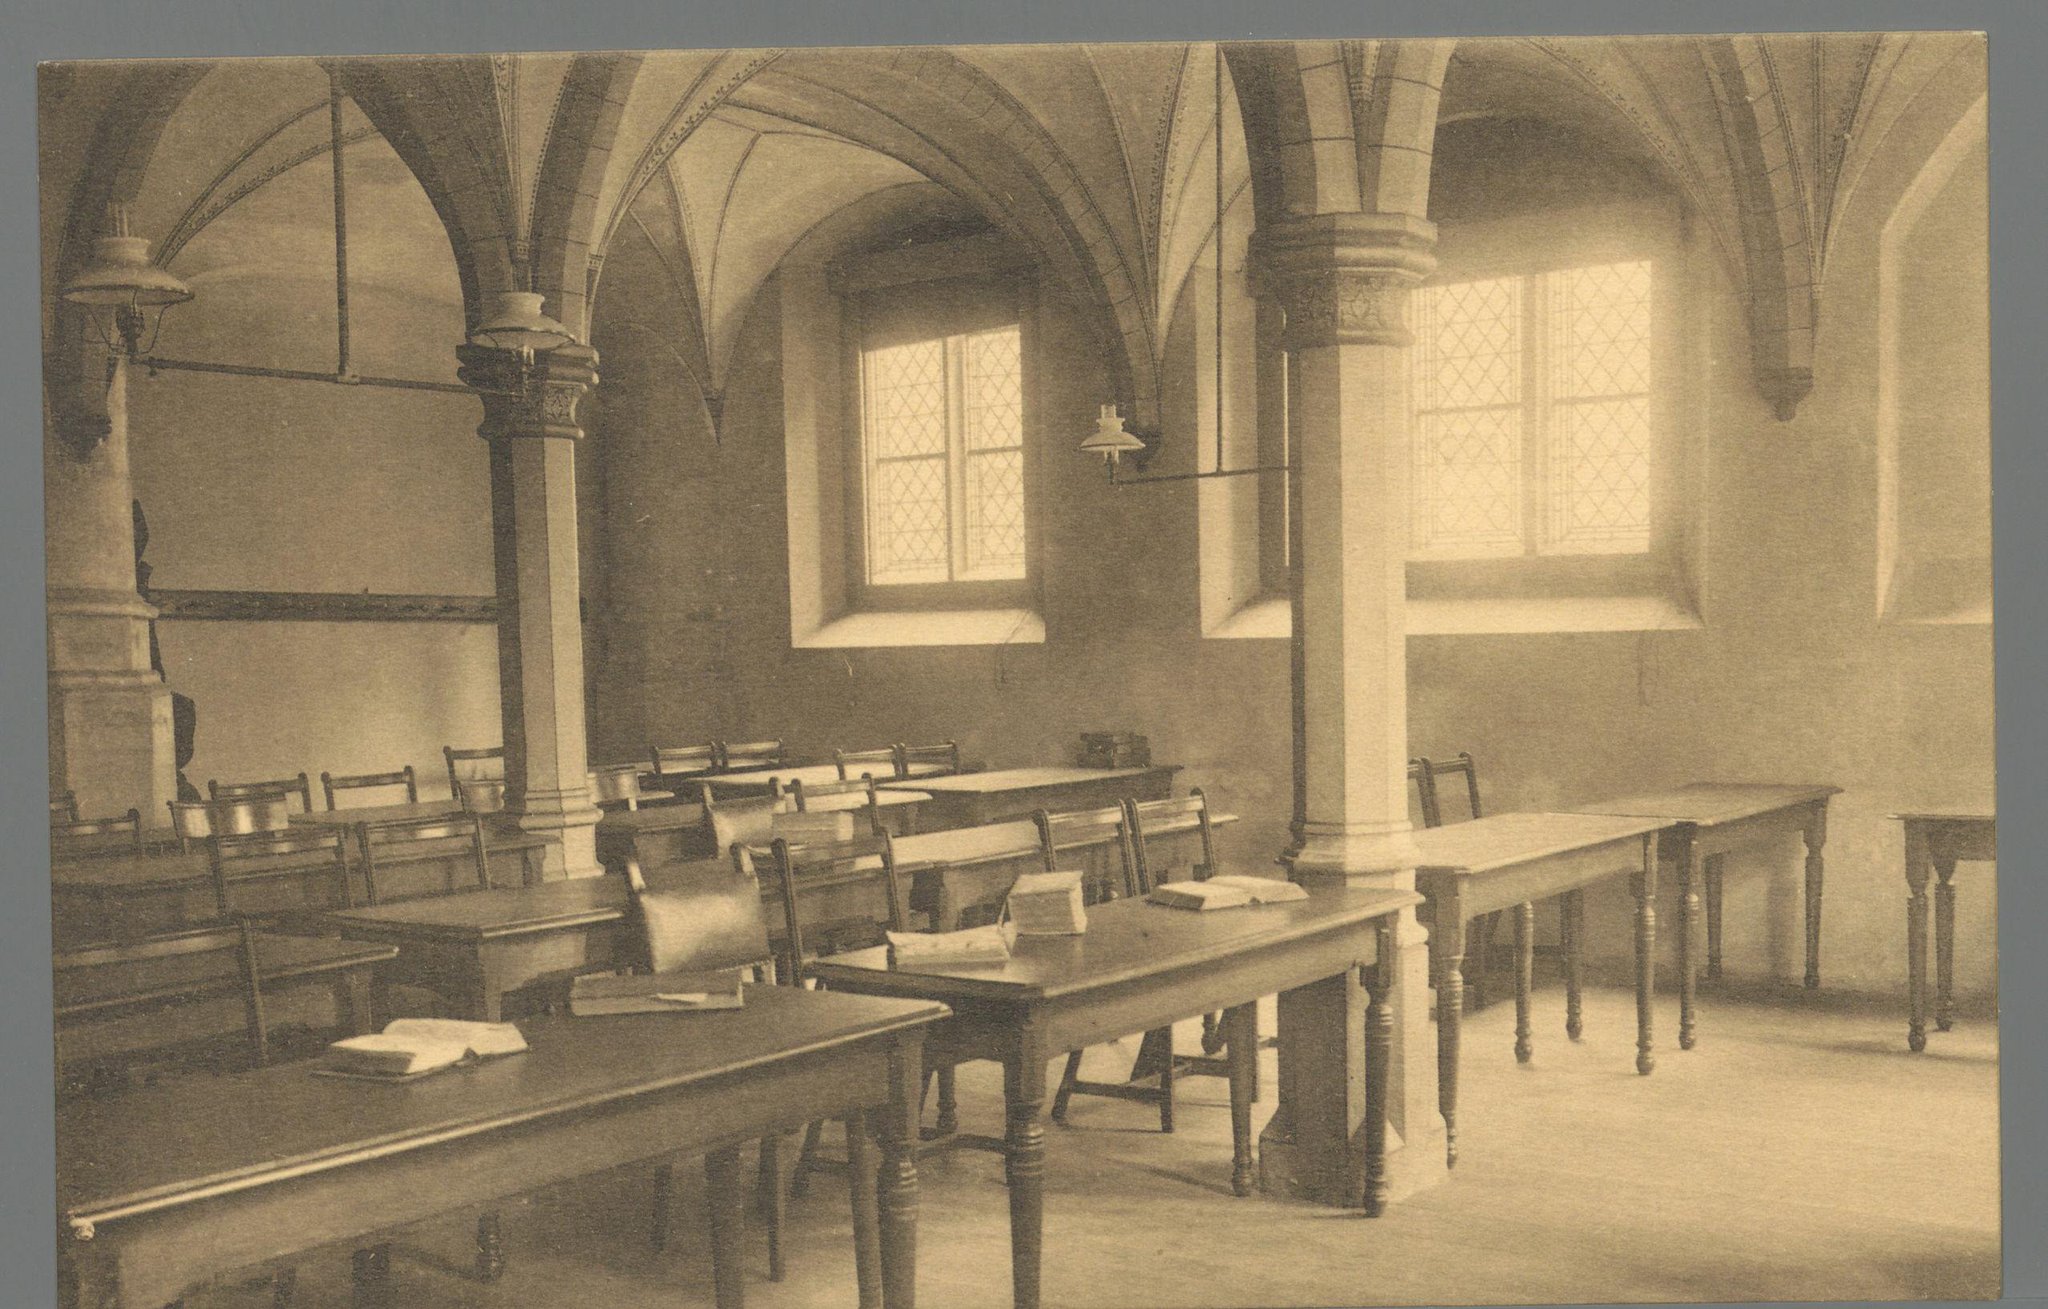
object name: photomechanical print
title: Leiden. Collegekamer Theologie. Rapenburg No. 25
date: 1905-1930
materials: cardboard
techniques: photograph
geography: leiden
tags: university building, college, leiden